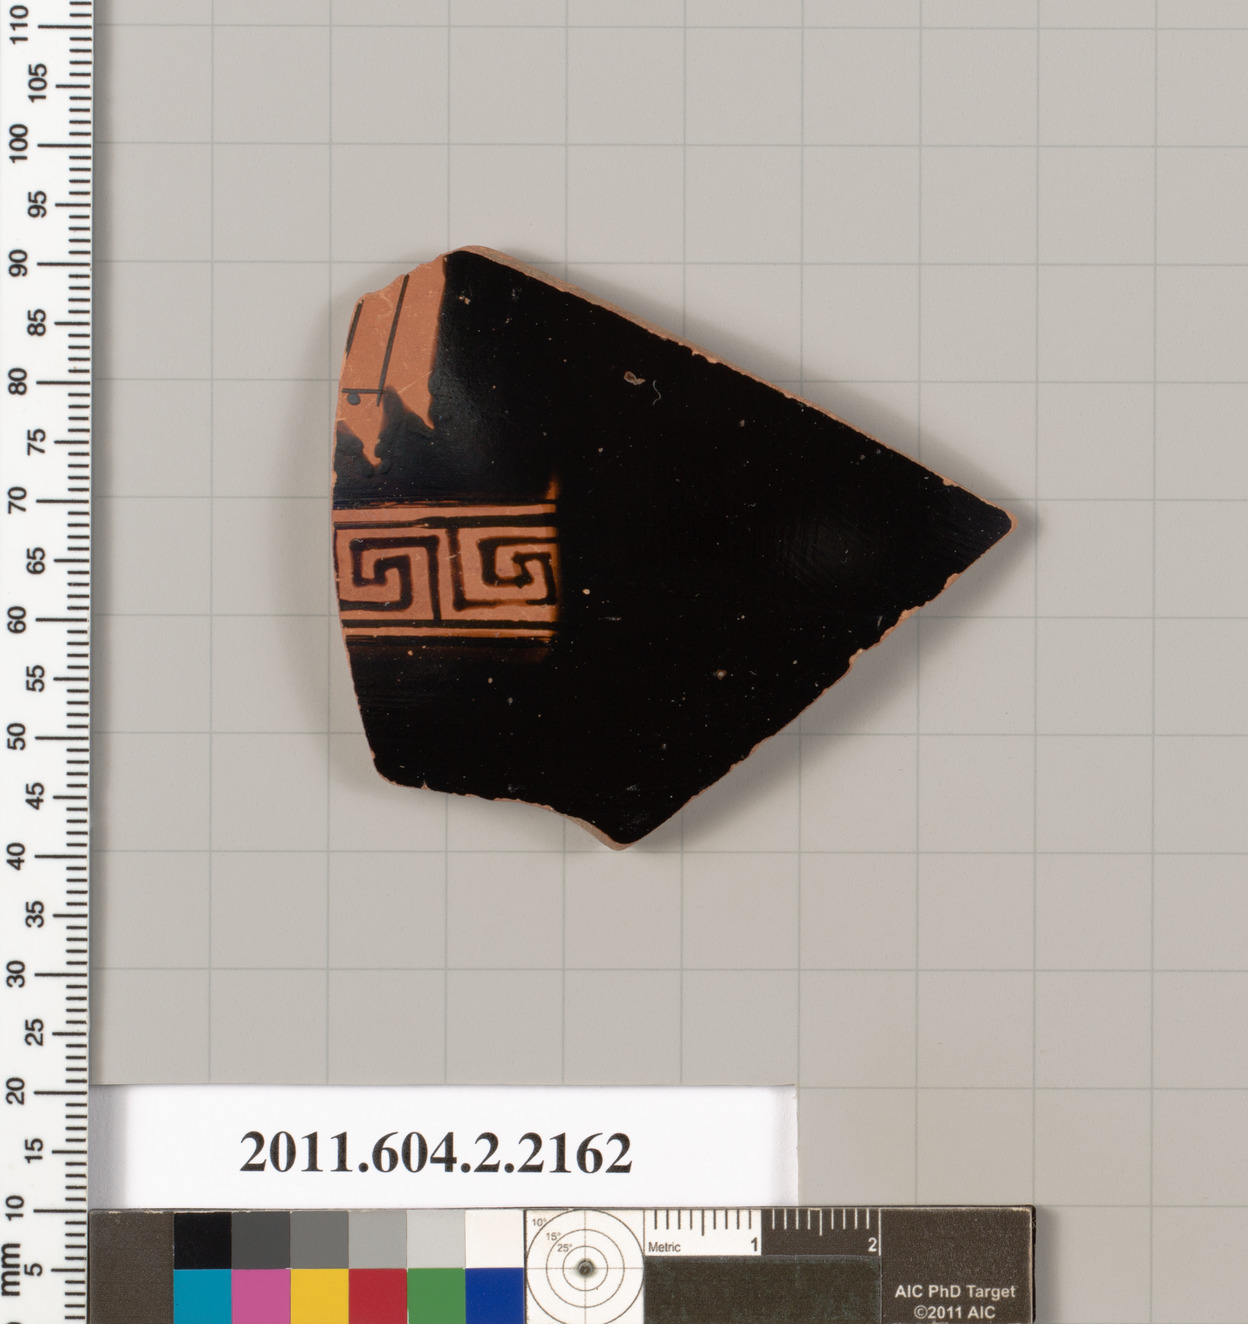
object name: pelike fragment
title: Terracotta fragment of a pelike?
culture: greek, attic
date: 480-470 BCE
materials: terracotta